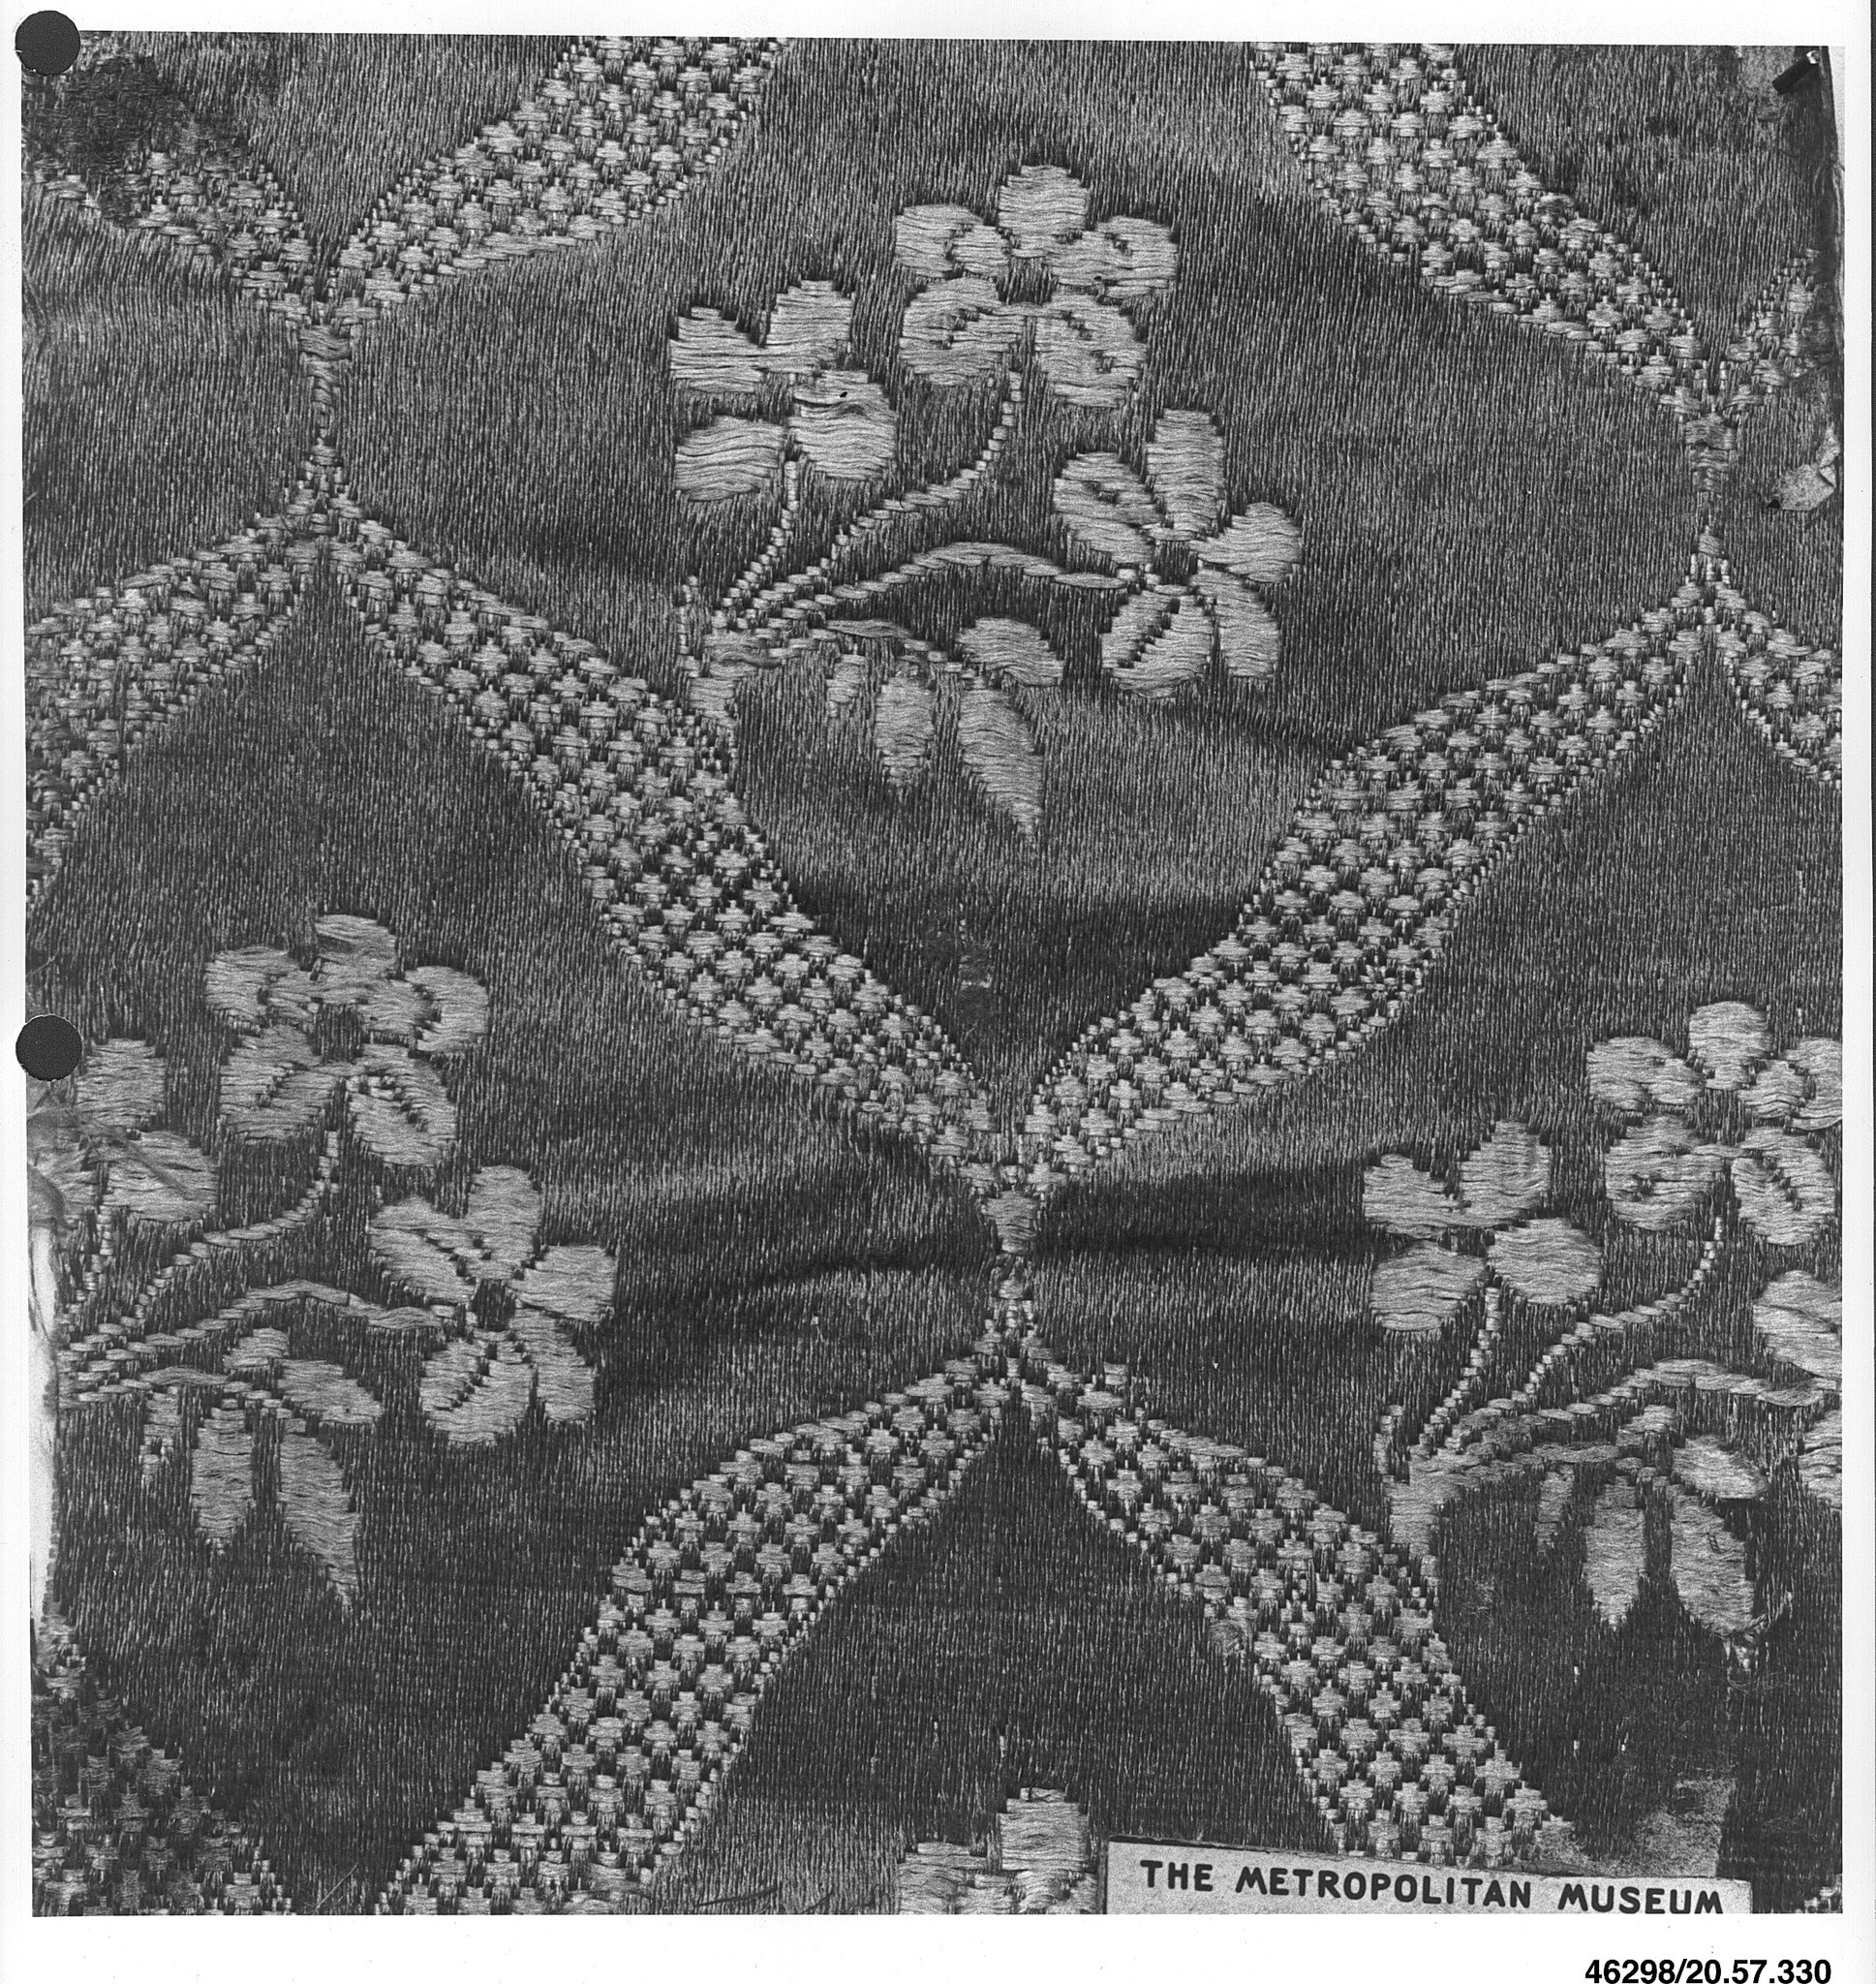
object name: piece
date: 1750-1760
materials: silk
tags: flowers,leaves